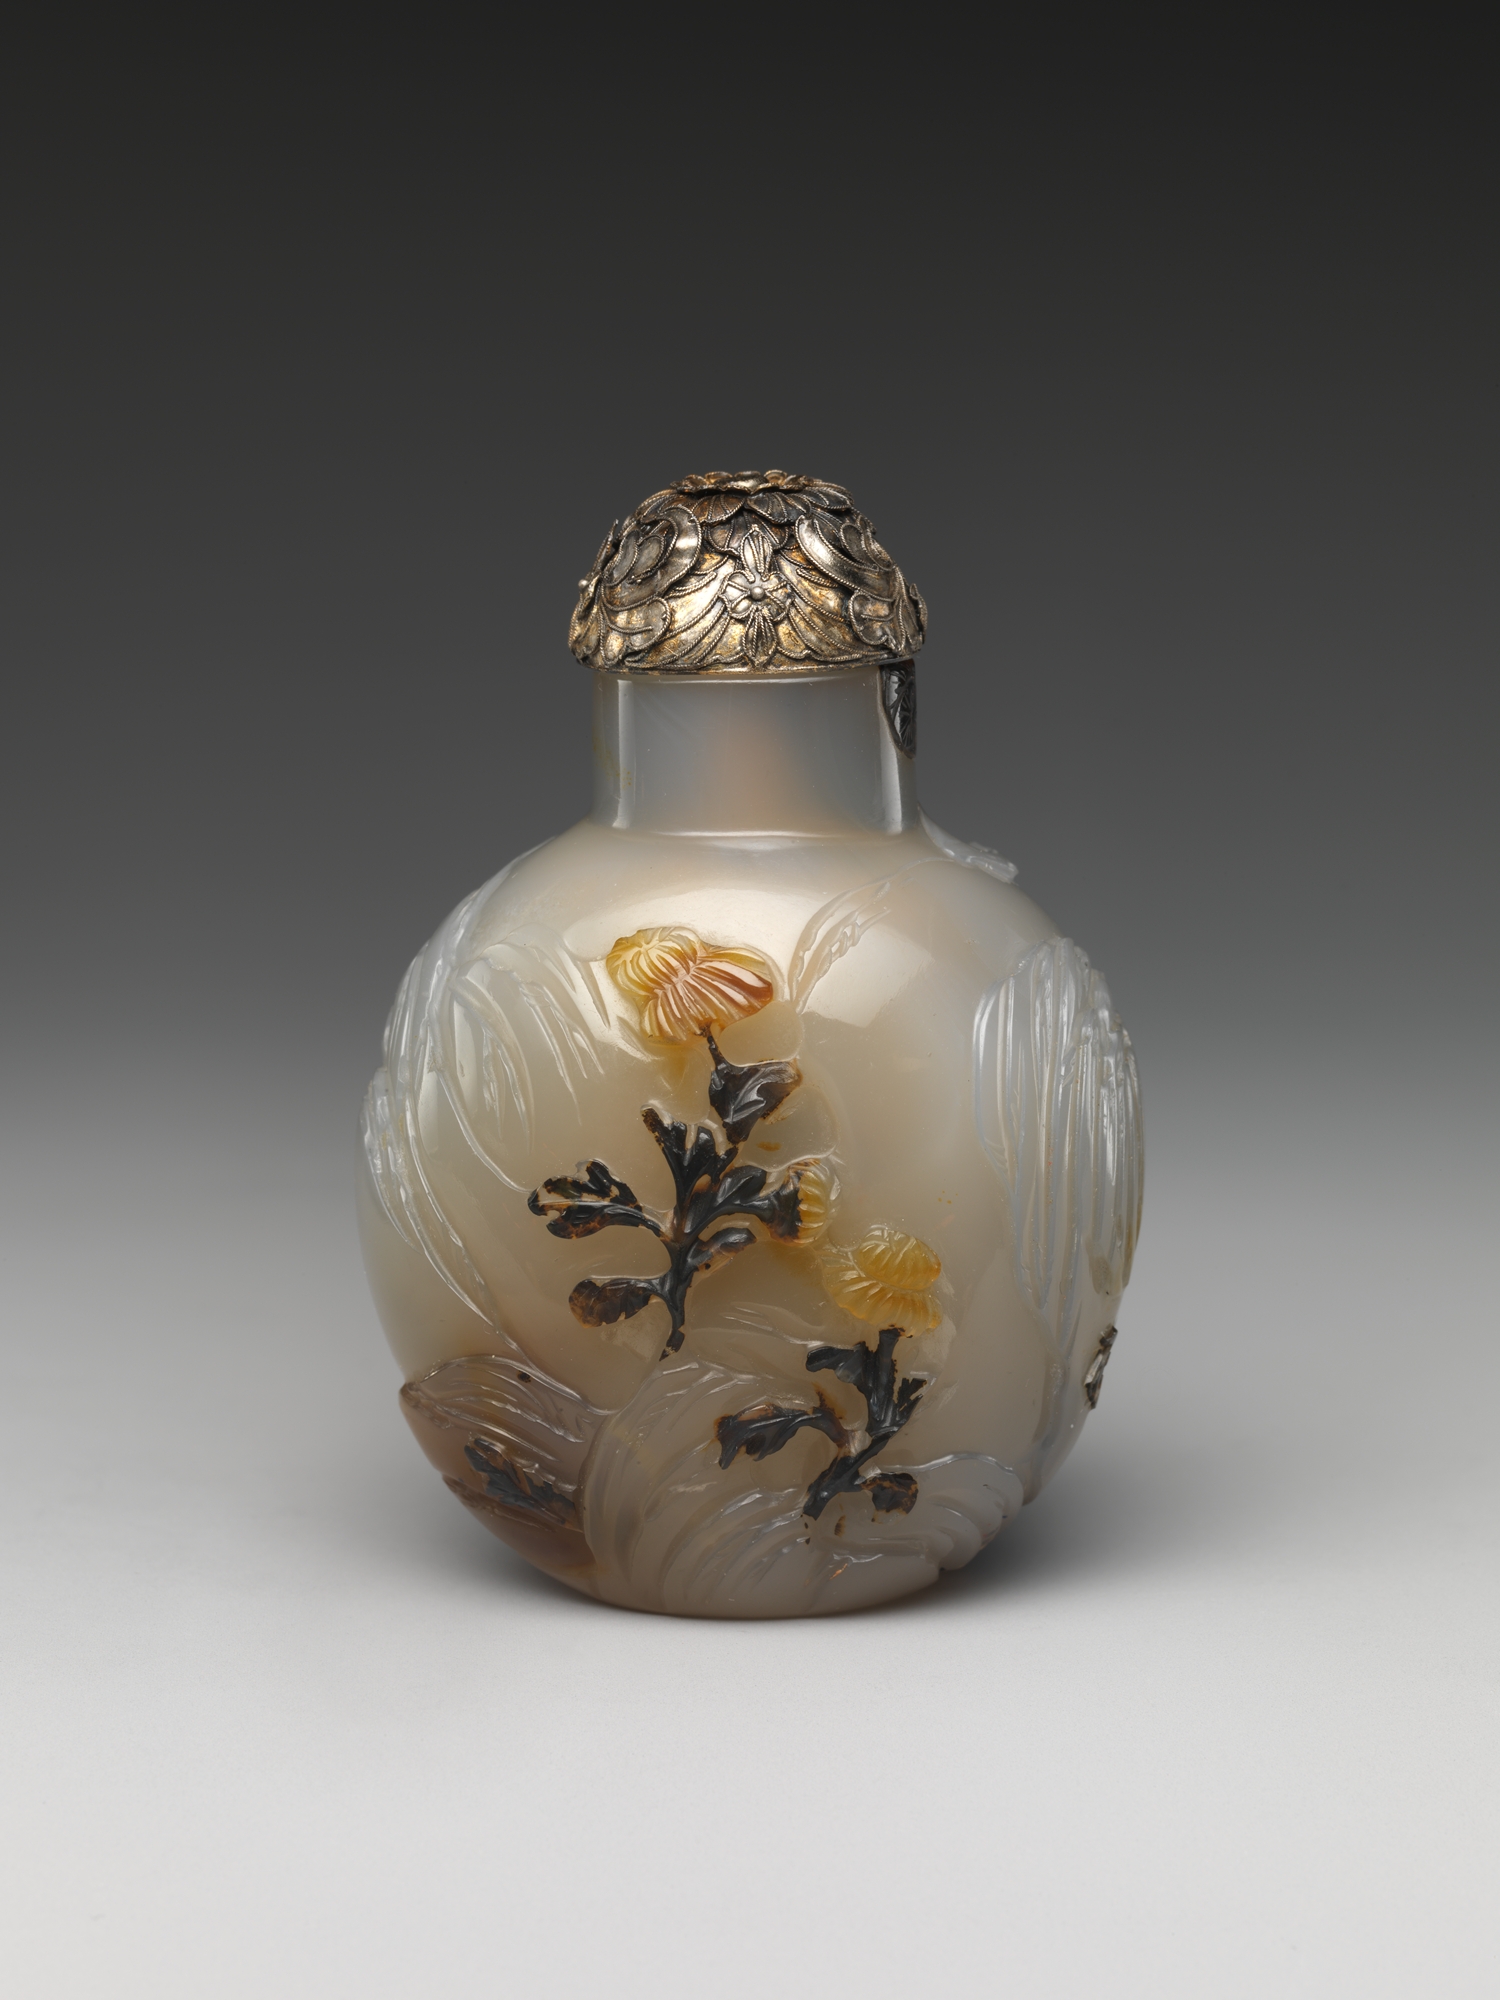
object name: snuff bottle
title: Snuff Bottle with Birds and Flowers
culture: chinese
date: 1767-1833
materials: stone, silver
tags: flowers